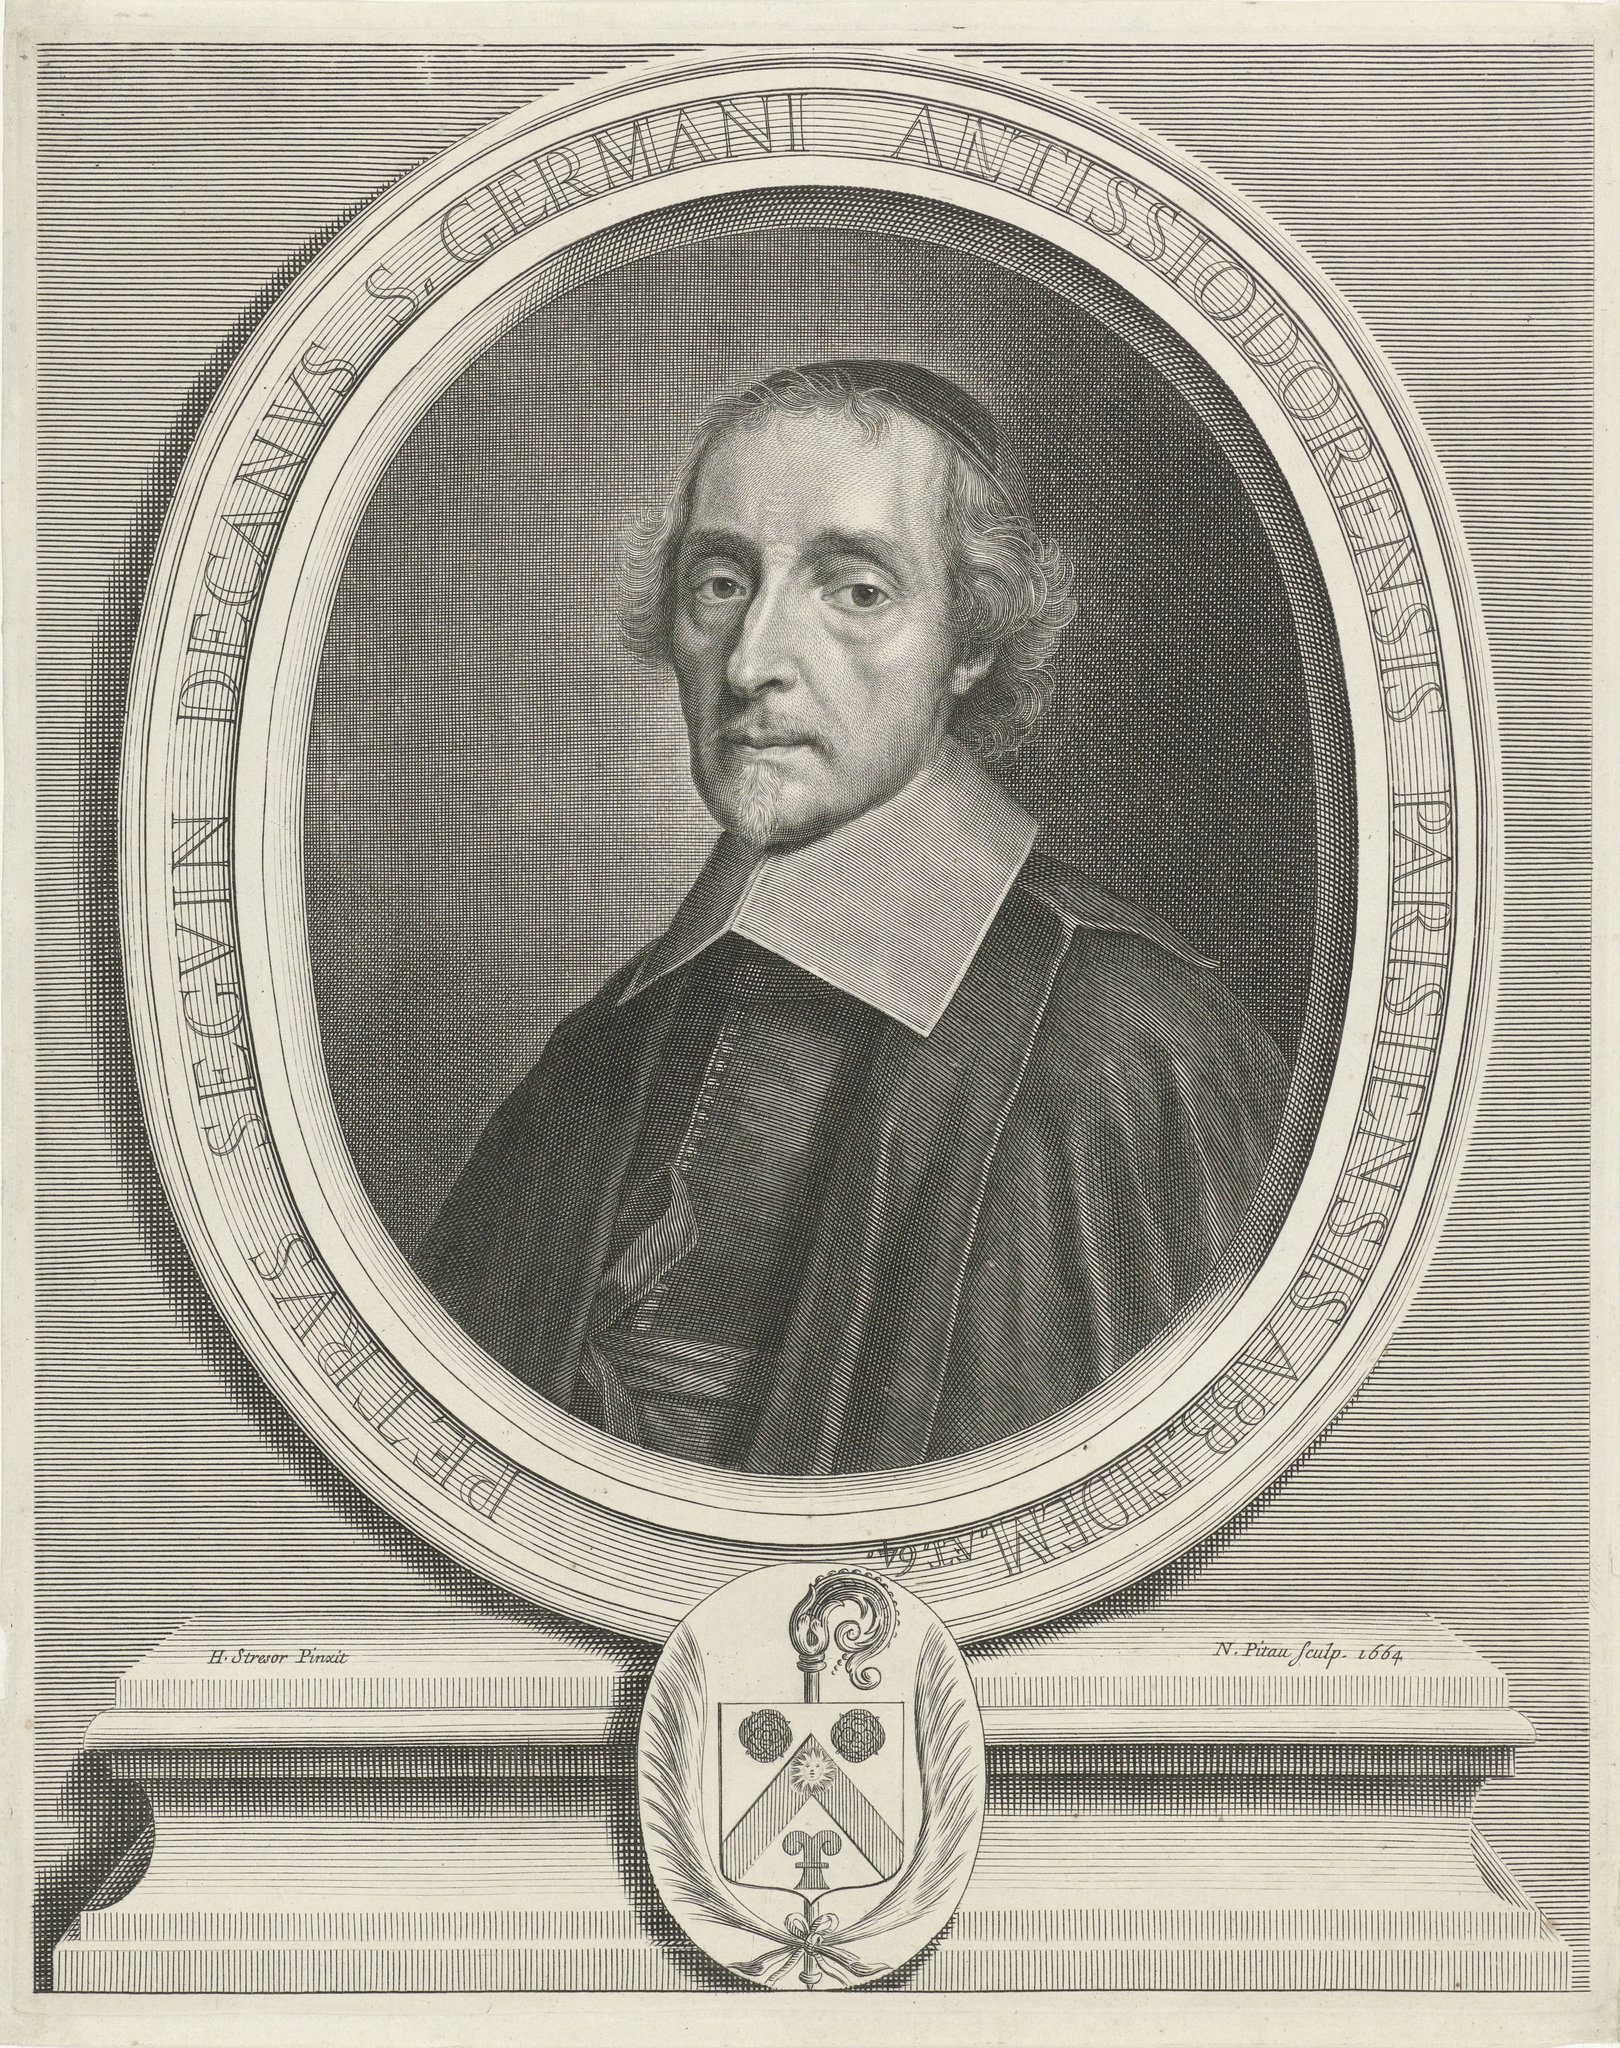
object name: print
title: Portret van Pierre Séguin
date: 1664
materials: paper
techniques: engraving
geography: paris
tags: armorial bearing, heraldry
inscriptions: collector's mark: Lugt 2228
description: Portret van Pierre Séguin, op 64-jarige leeftijd. Op de piëdestal zijn wapenschild.